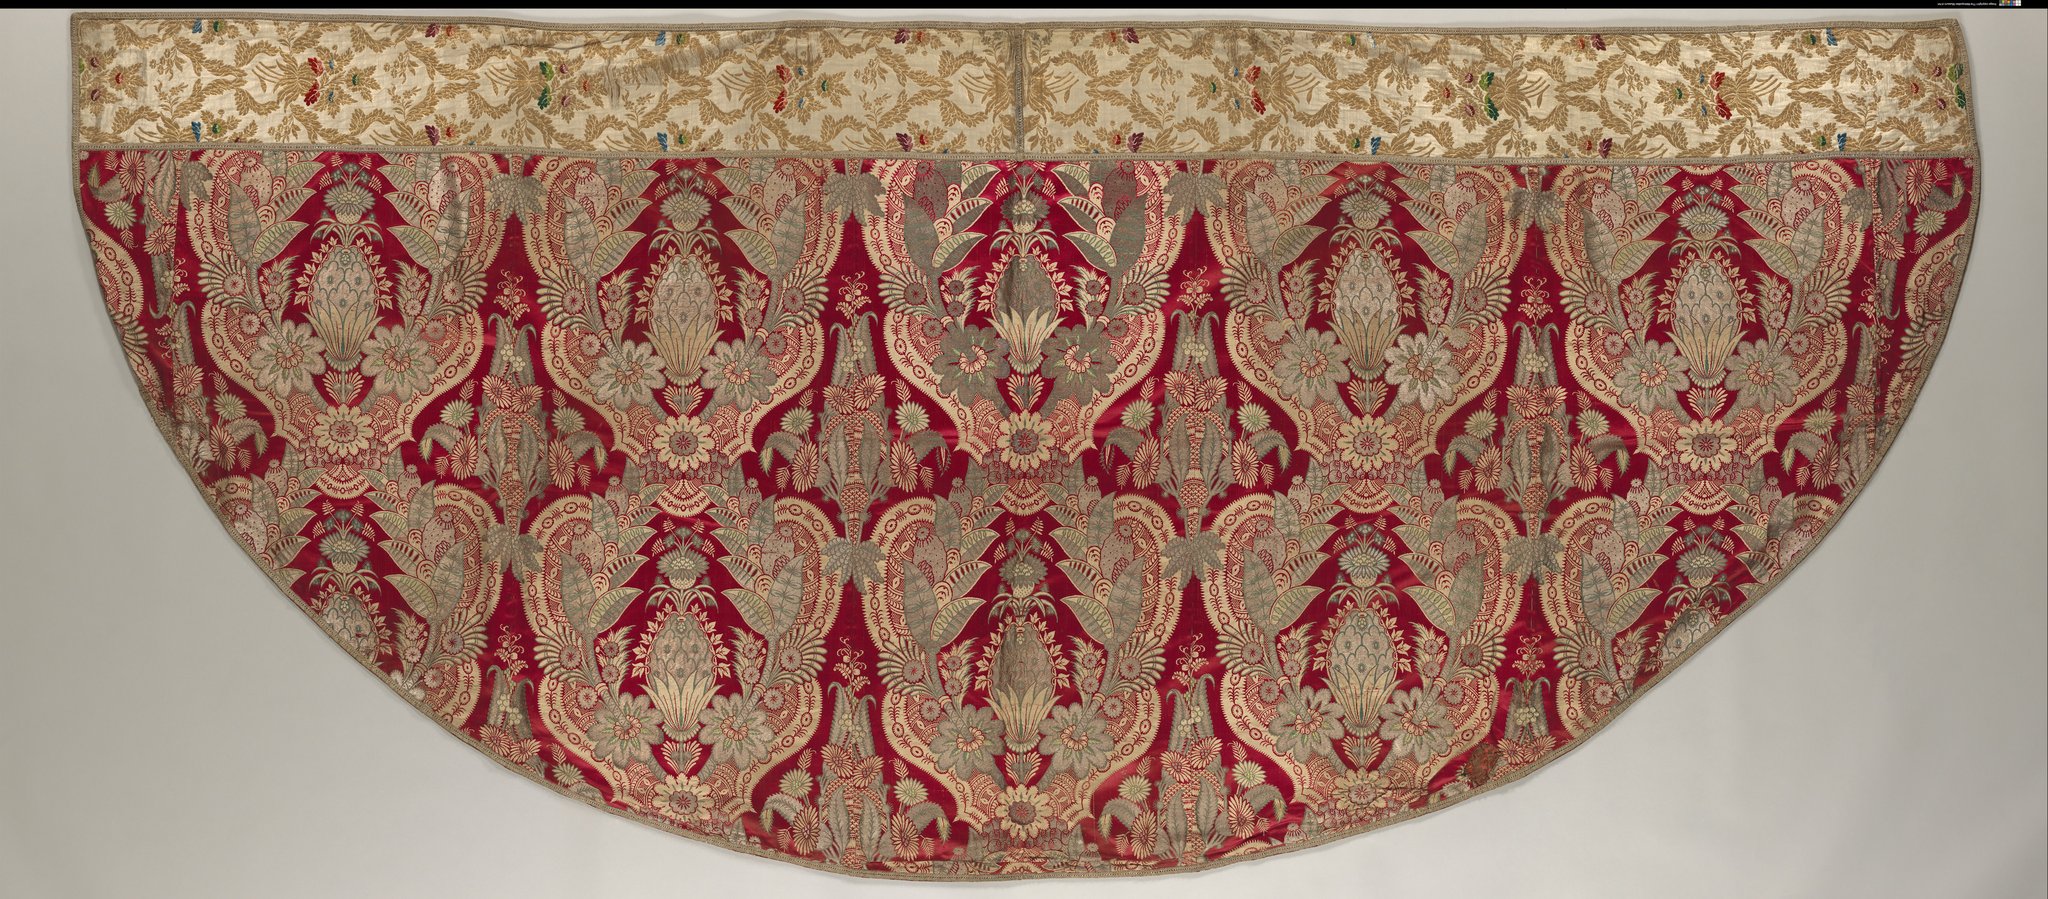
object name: cope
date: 1725-1730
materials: metal thread, silk